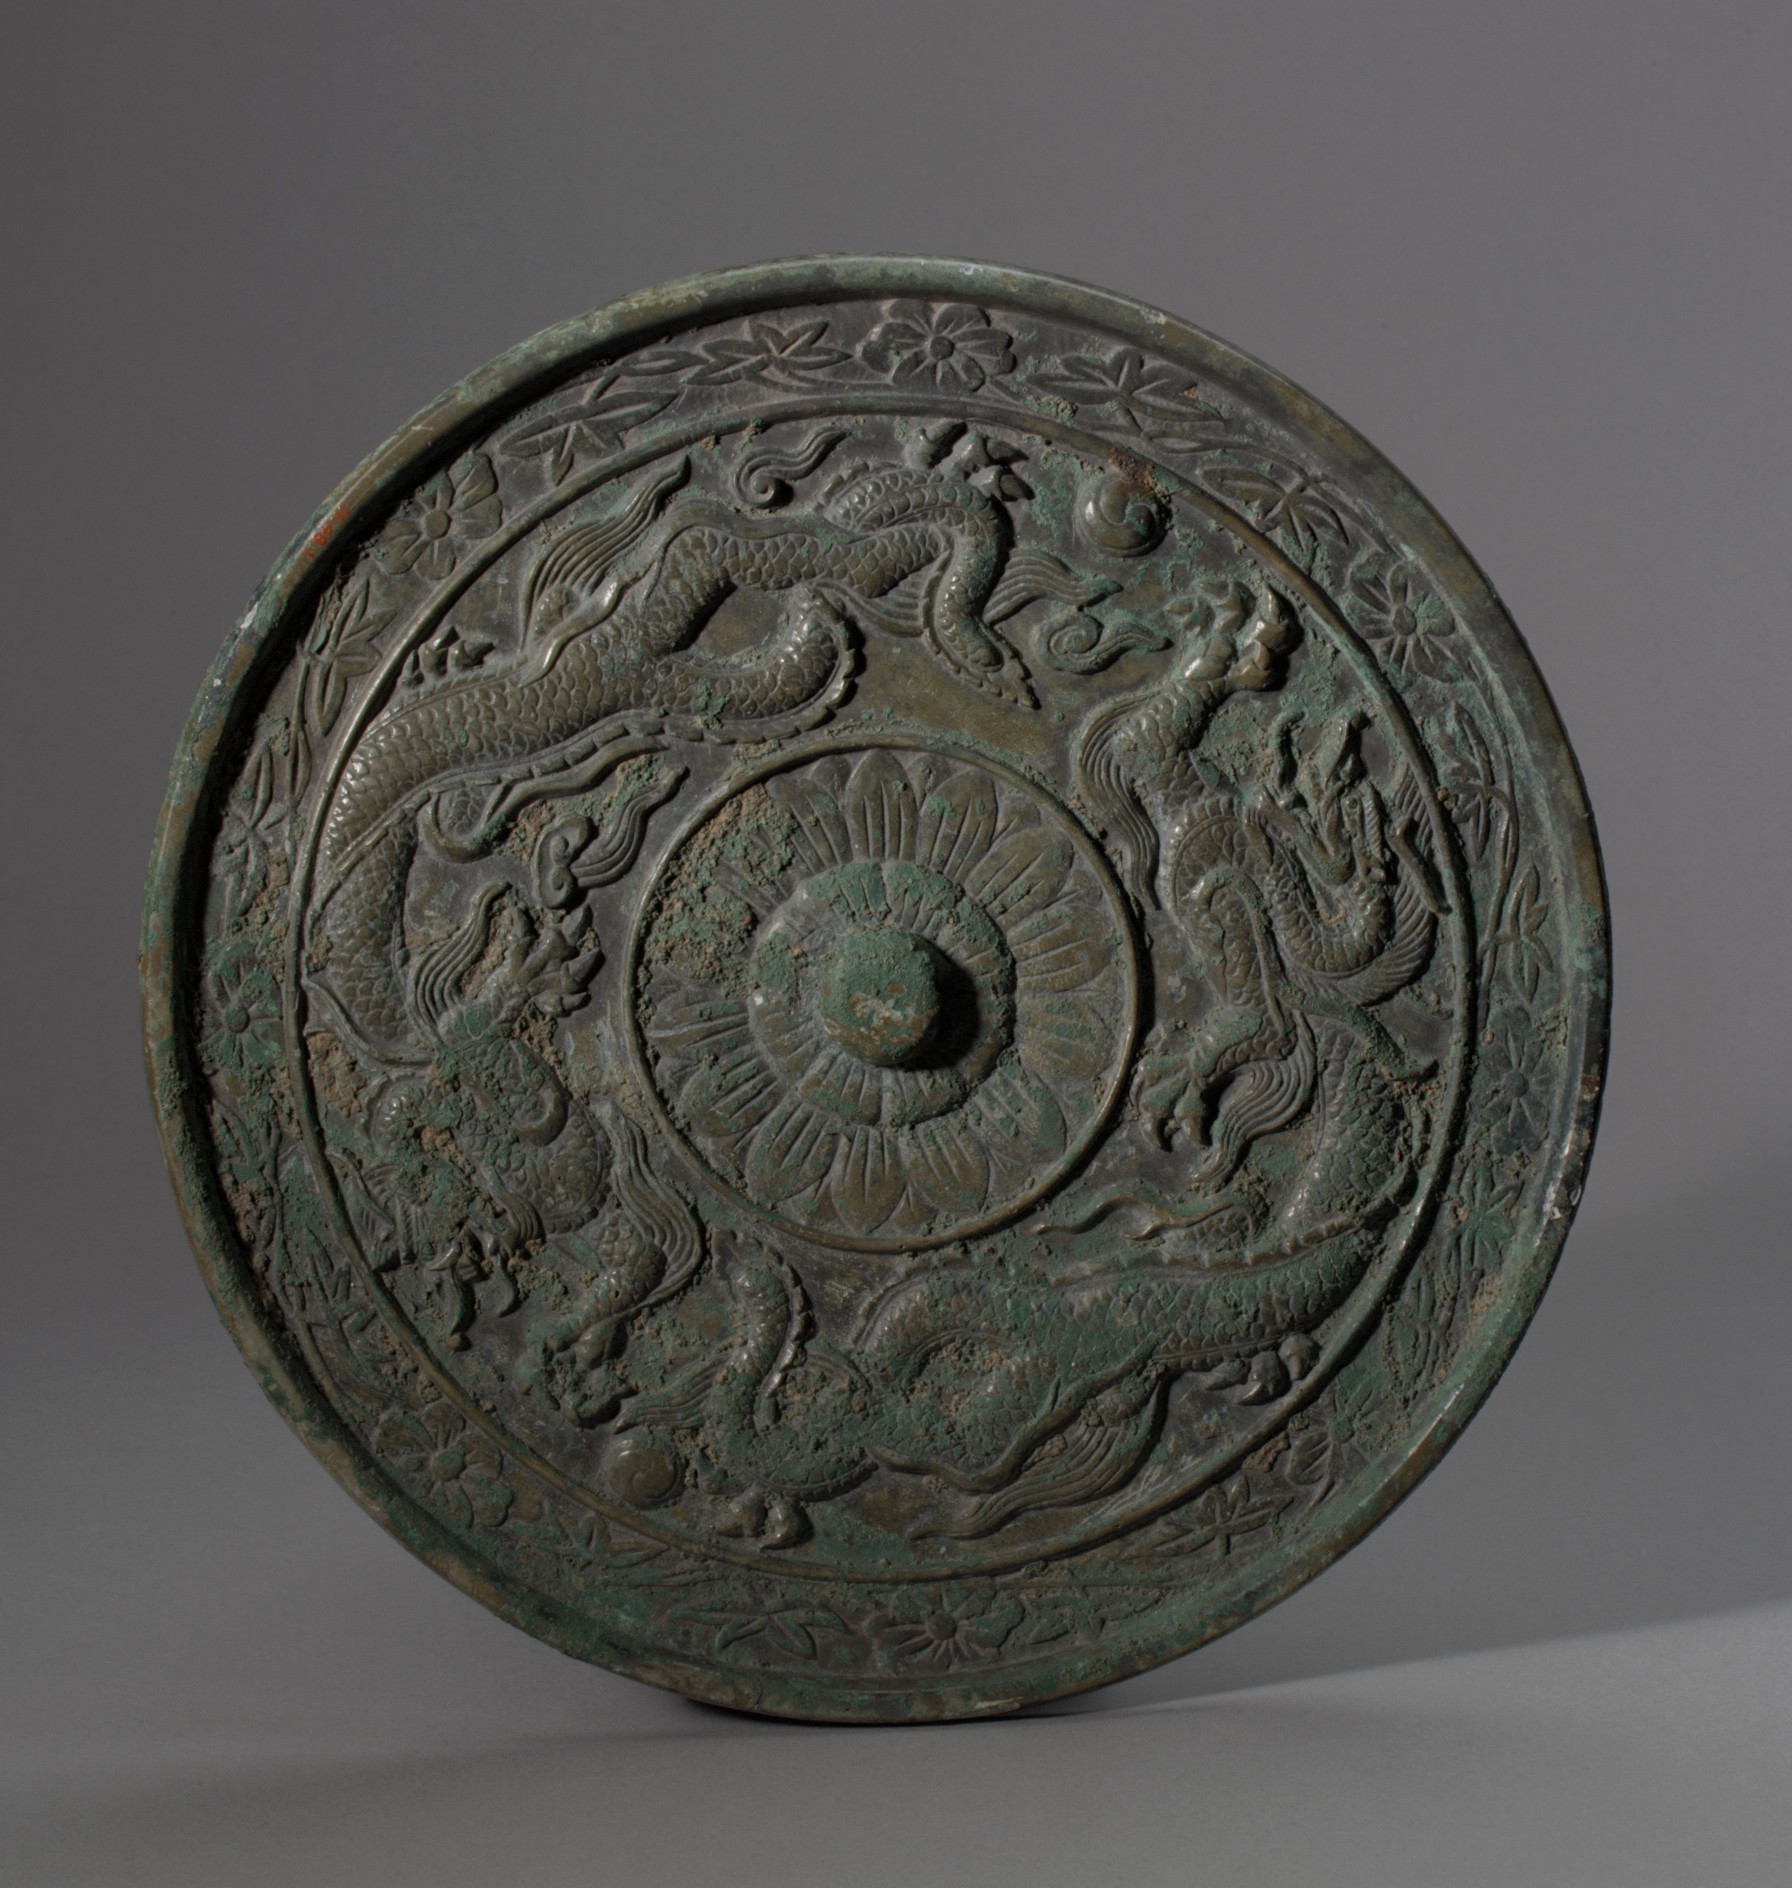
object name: mirror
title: Mirror decorated with dragons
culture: korean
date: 1001-1200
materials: bronze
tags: dragons